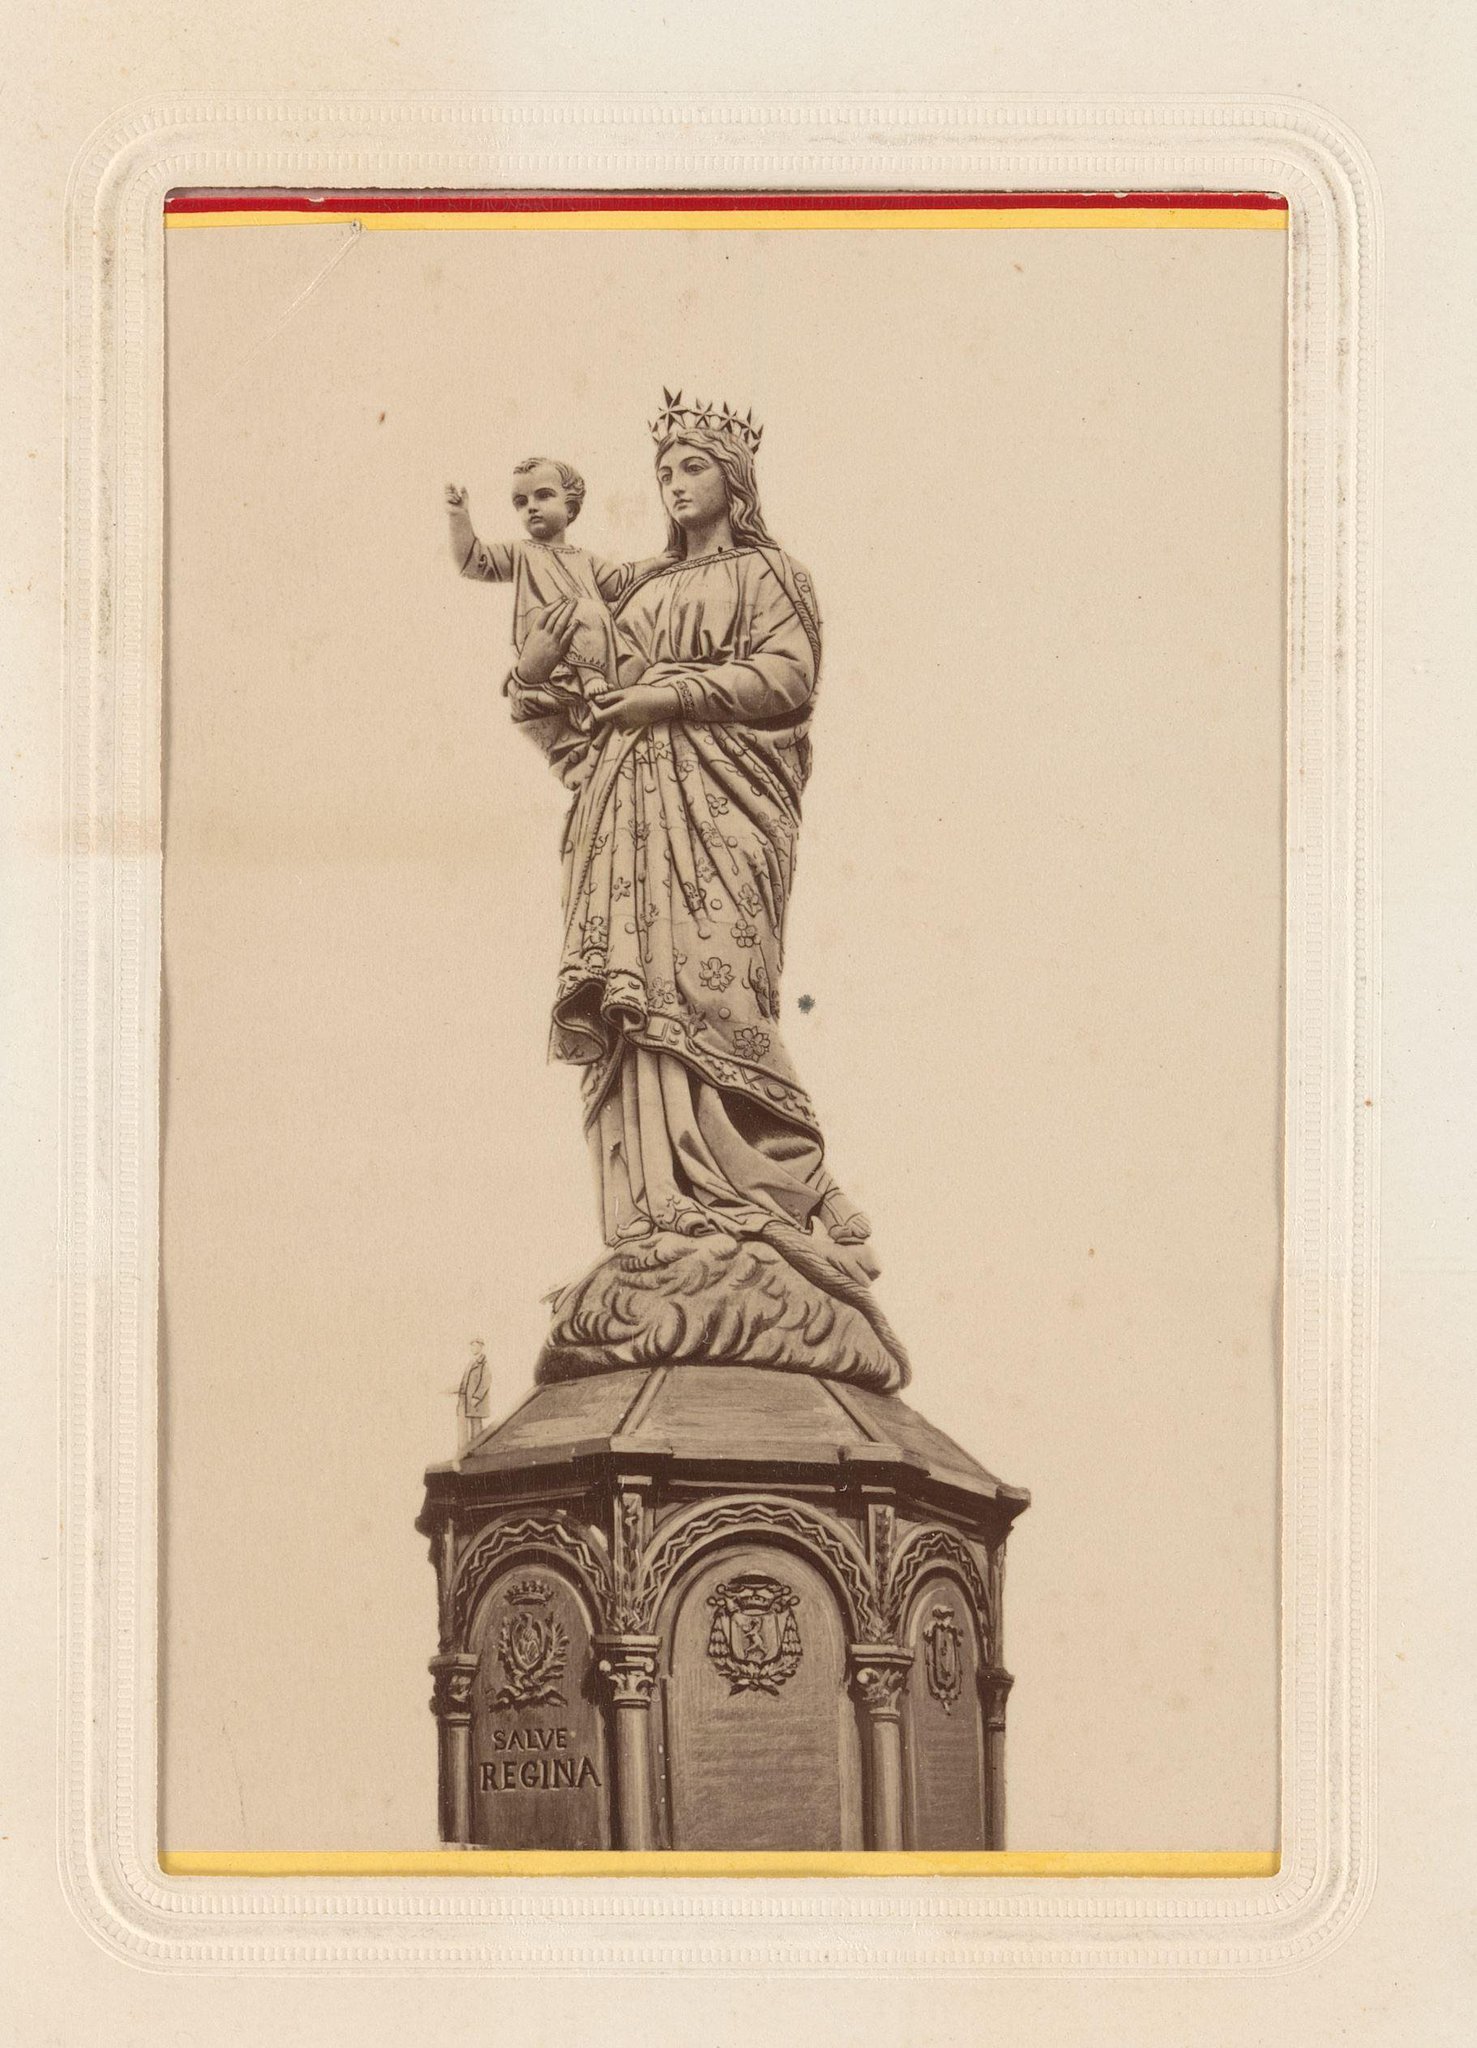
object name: cabinet photograph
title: Fotoreproductie van een schilderij van Salve Regina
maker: Anonymous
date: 1867-1900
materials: cardboard, paper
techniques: albumen print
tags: 'regina coeli', 'regina angelorum', 'maestà' ~ madonna